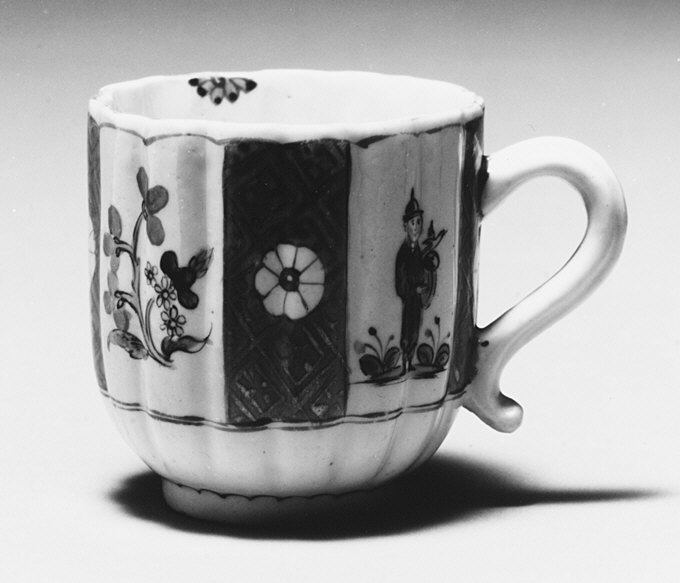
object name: cup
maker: derby porcelain manufactory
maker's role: factory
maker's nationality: british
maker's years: 1751-1785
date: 1760-1770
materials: soft paste porcelain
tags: men,flowers